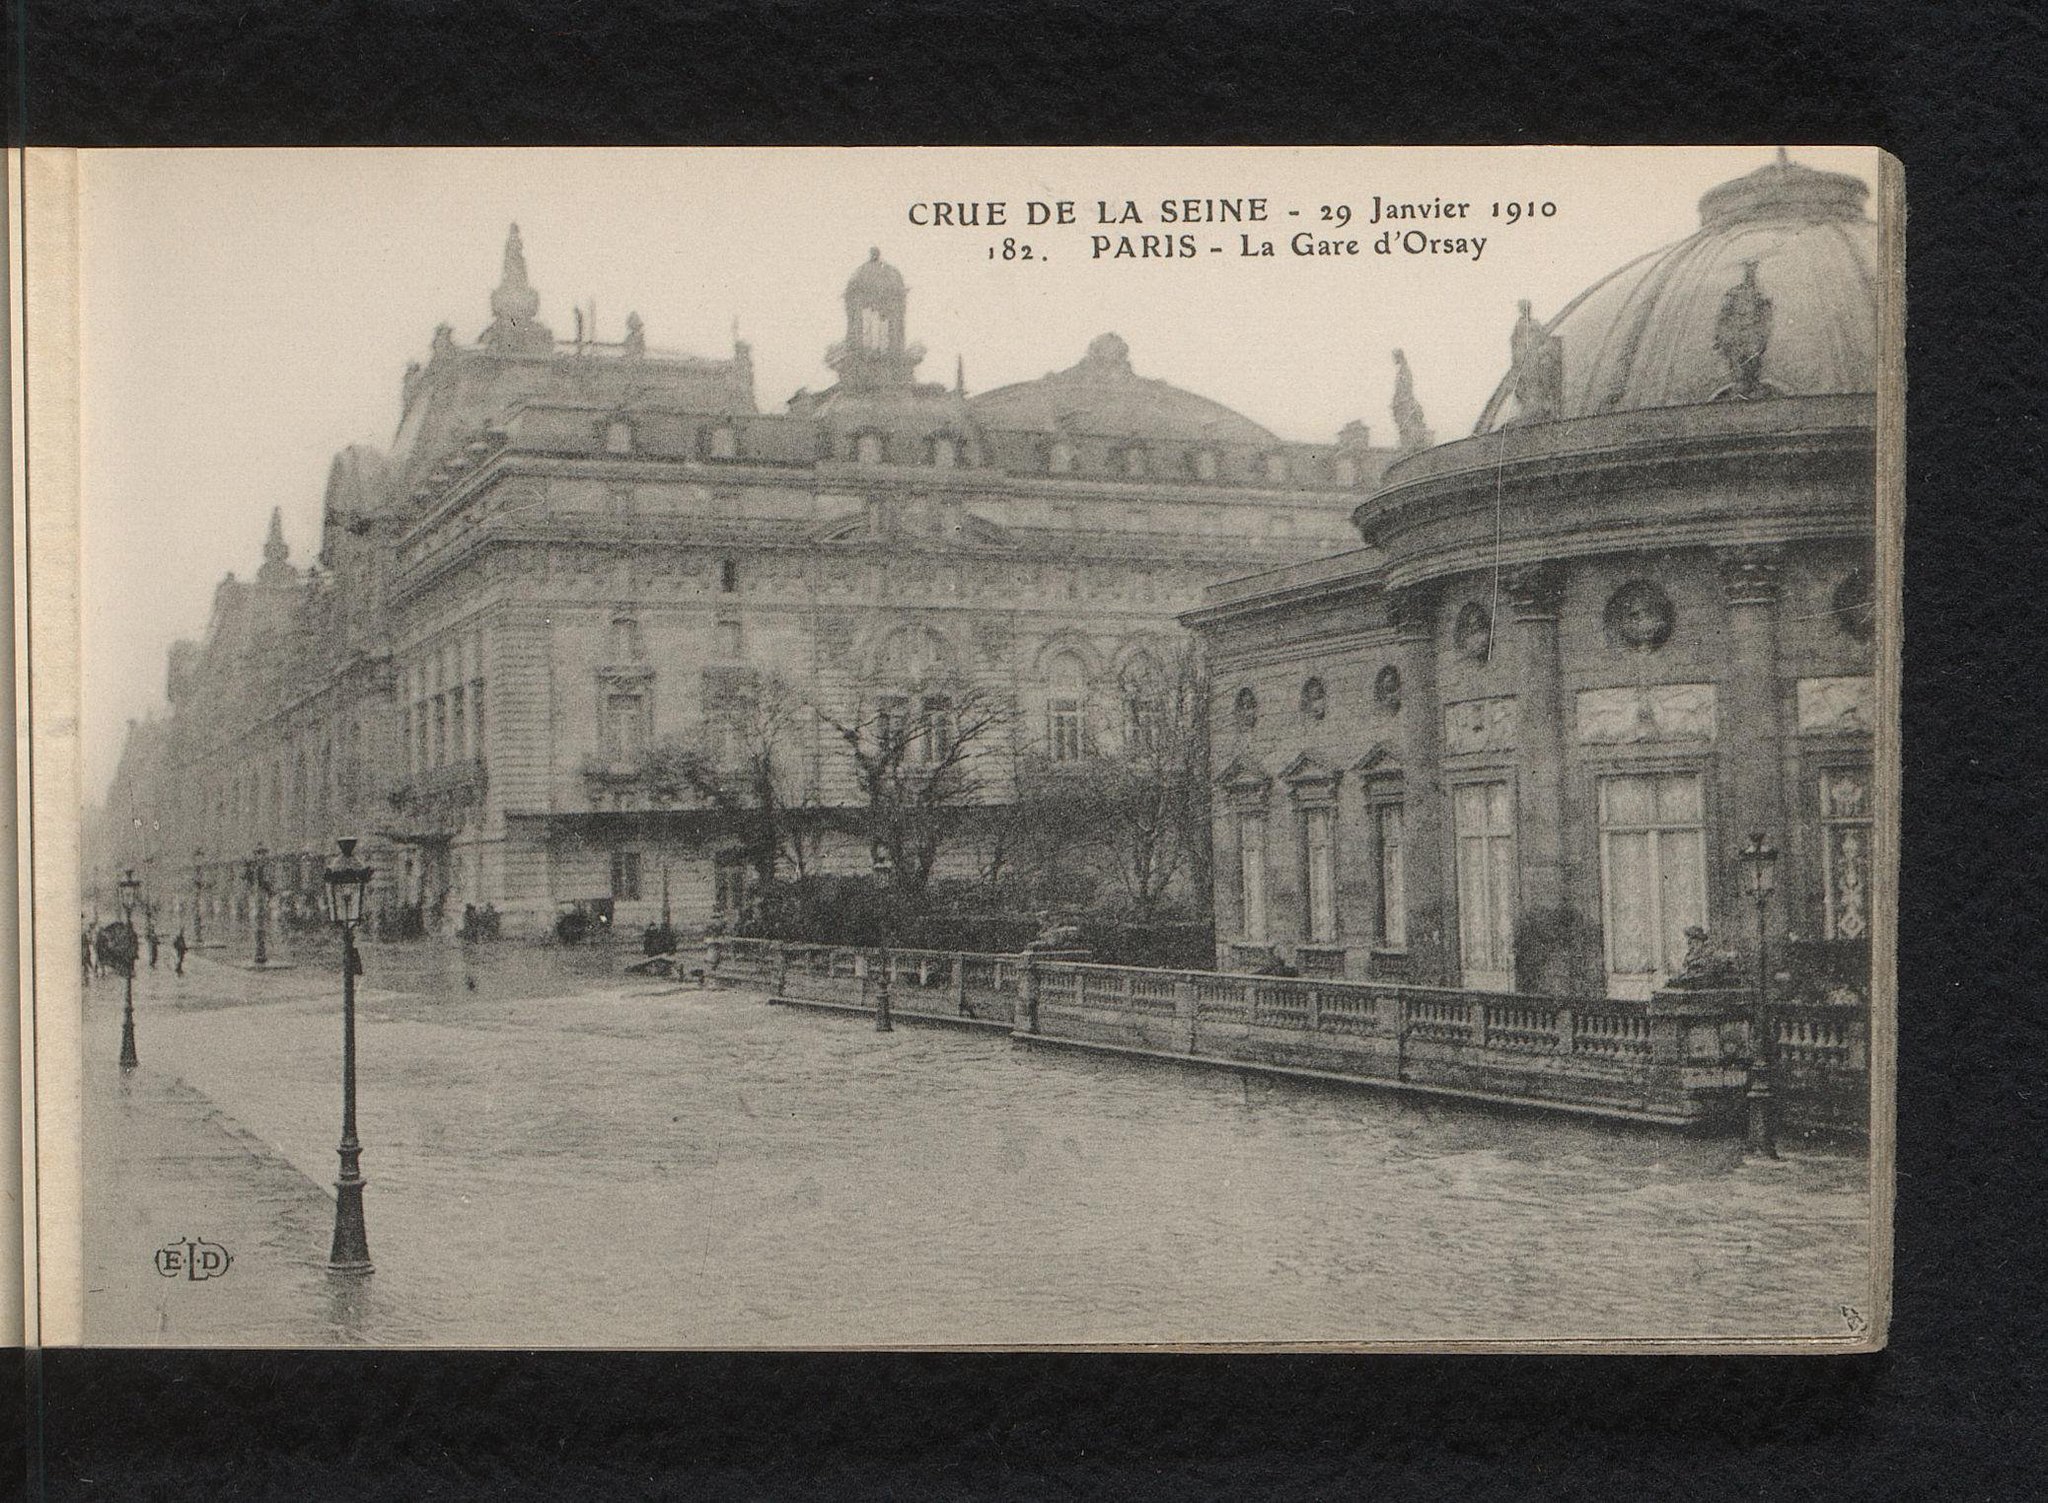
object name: ansichtkaart, prentbriefkaart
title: 29 Janvier 1910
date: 1910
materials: cardboard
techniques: photograph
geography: paris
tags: flood, station; shelter (railway, tramway)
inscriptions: date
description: Prentbriefkaart maakt deel uit van een album.